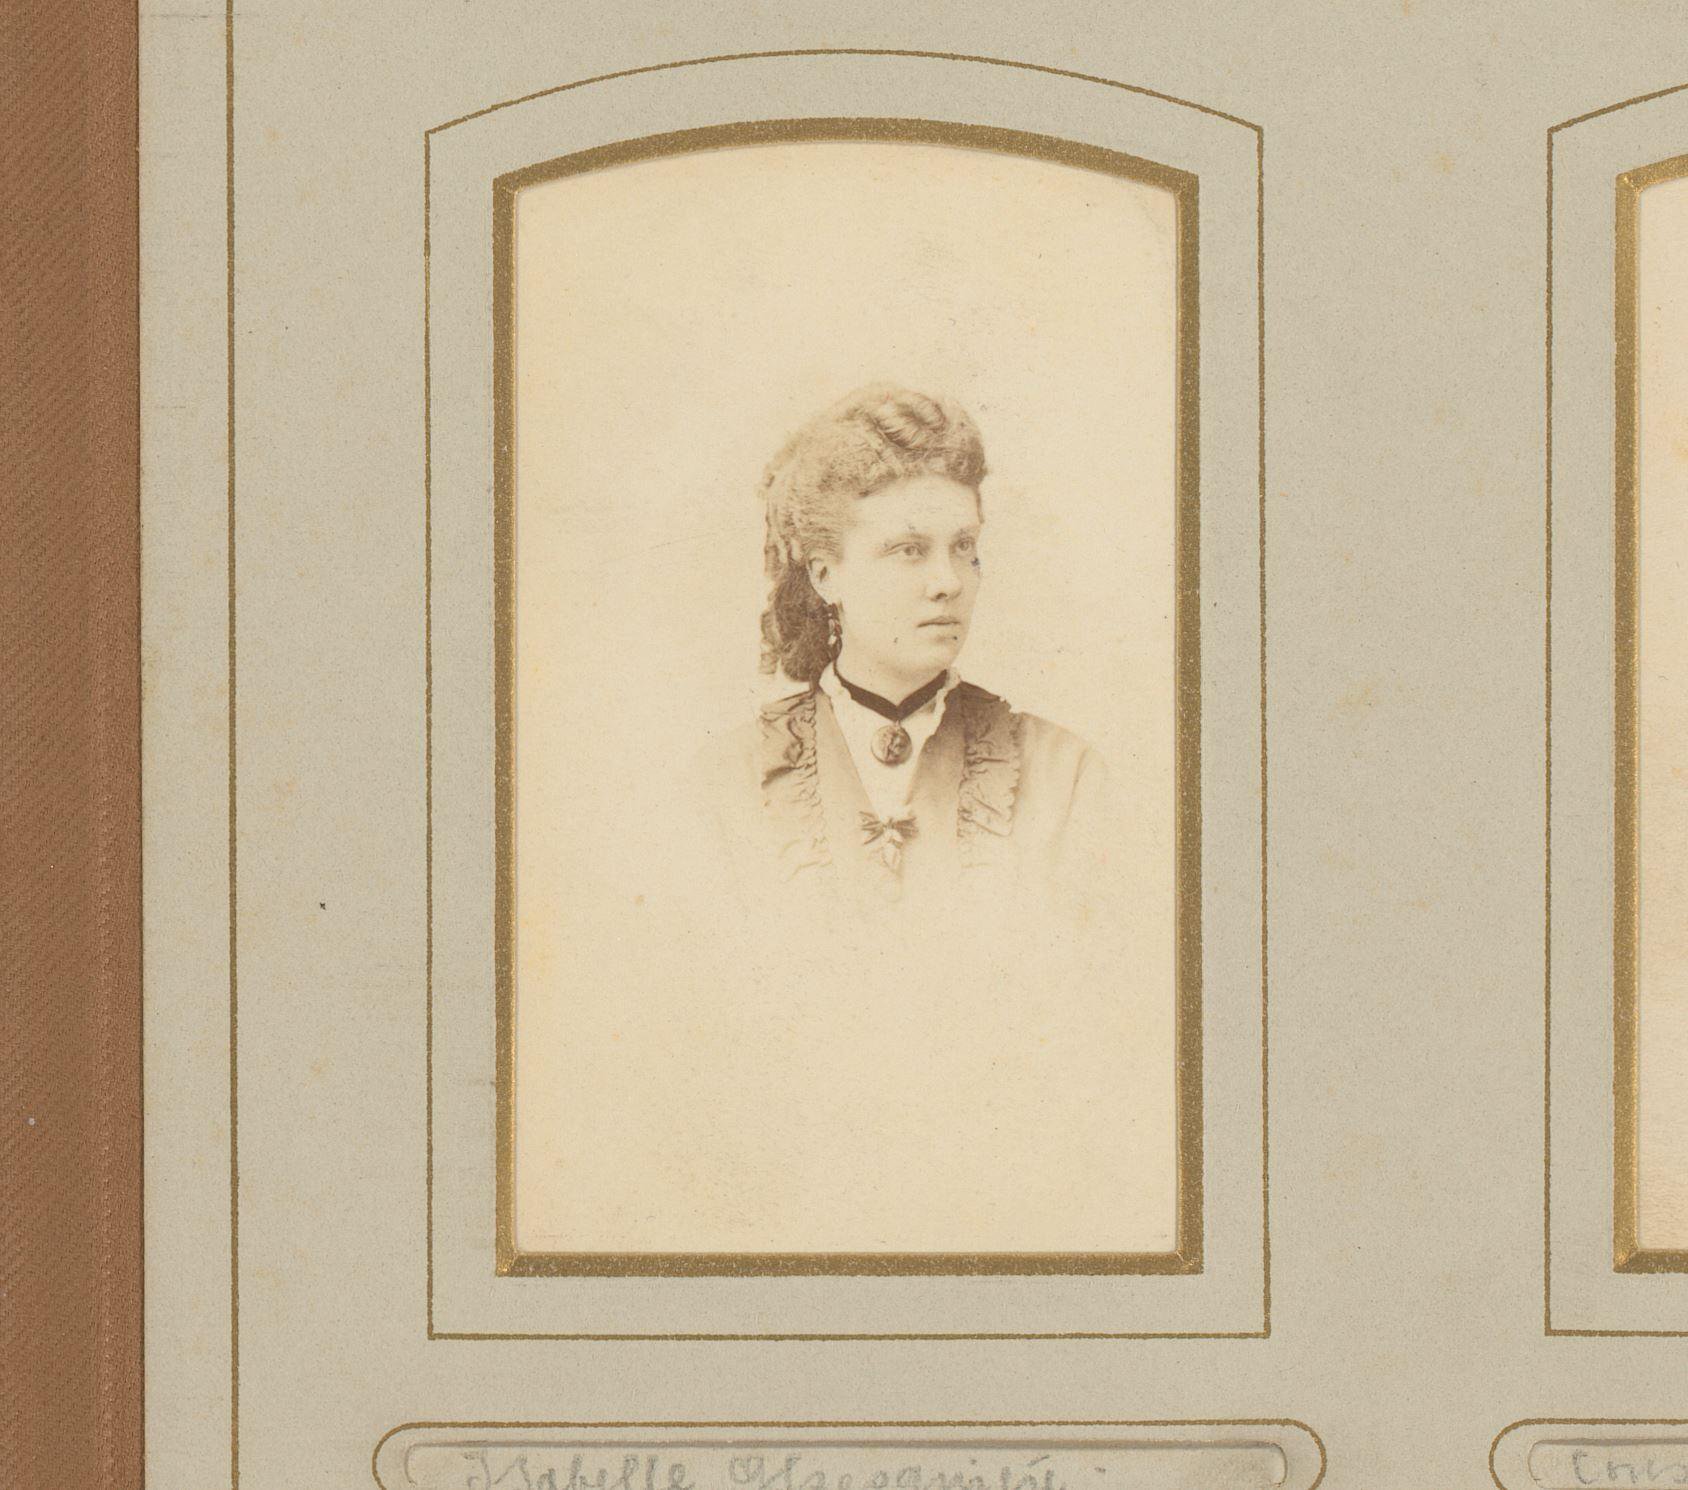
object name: photograph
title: Portret van een vrouw, aangeduid als Isabelle Ghesquiere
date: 1866-1900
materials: cardboard, photographic support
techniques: albumen print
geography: brussels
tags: historical persons - bb - woman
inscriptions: inscription: ‘GÉRUZET FRÈRES/ PHOTOGRAPHES/ de S.M. la Reine des Belges./ 27bis Rue de L'Ecuyer./ BRUXELLES./ Les Clichés se conservant indéfiniment/ on peut toujours se procurer de nouvelles/ épreuves de ce Portrait sans reposer.’, name: ‘Isabelle Ghesquiere’